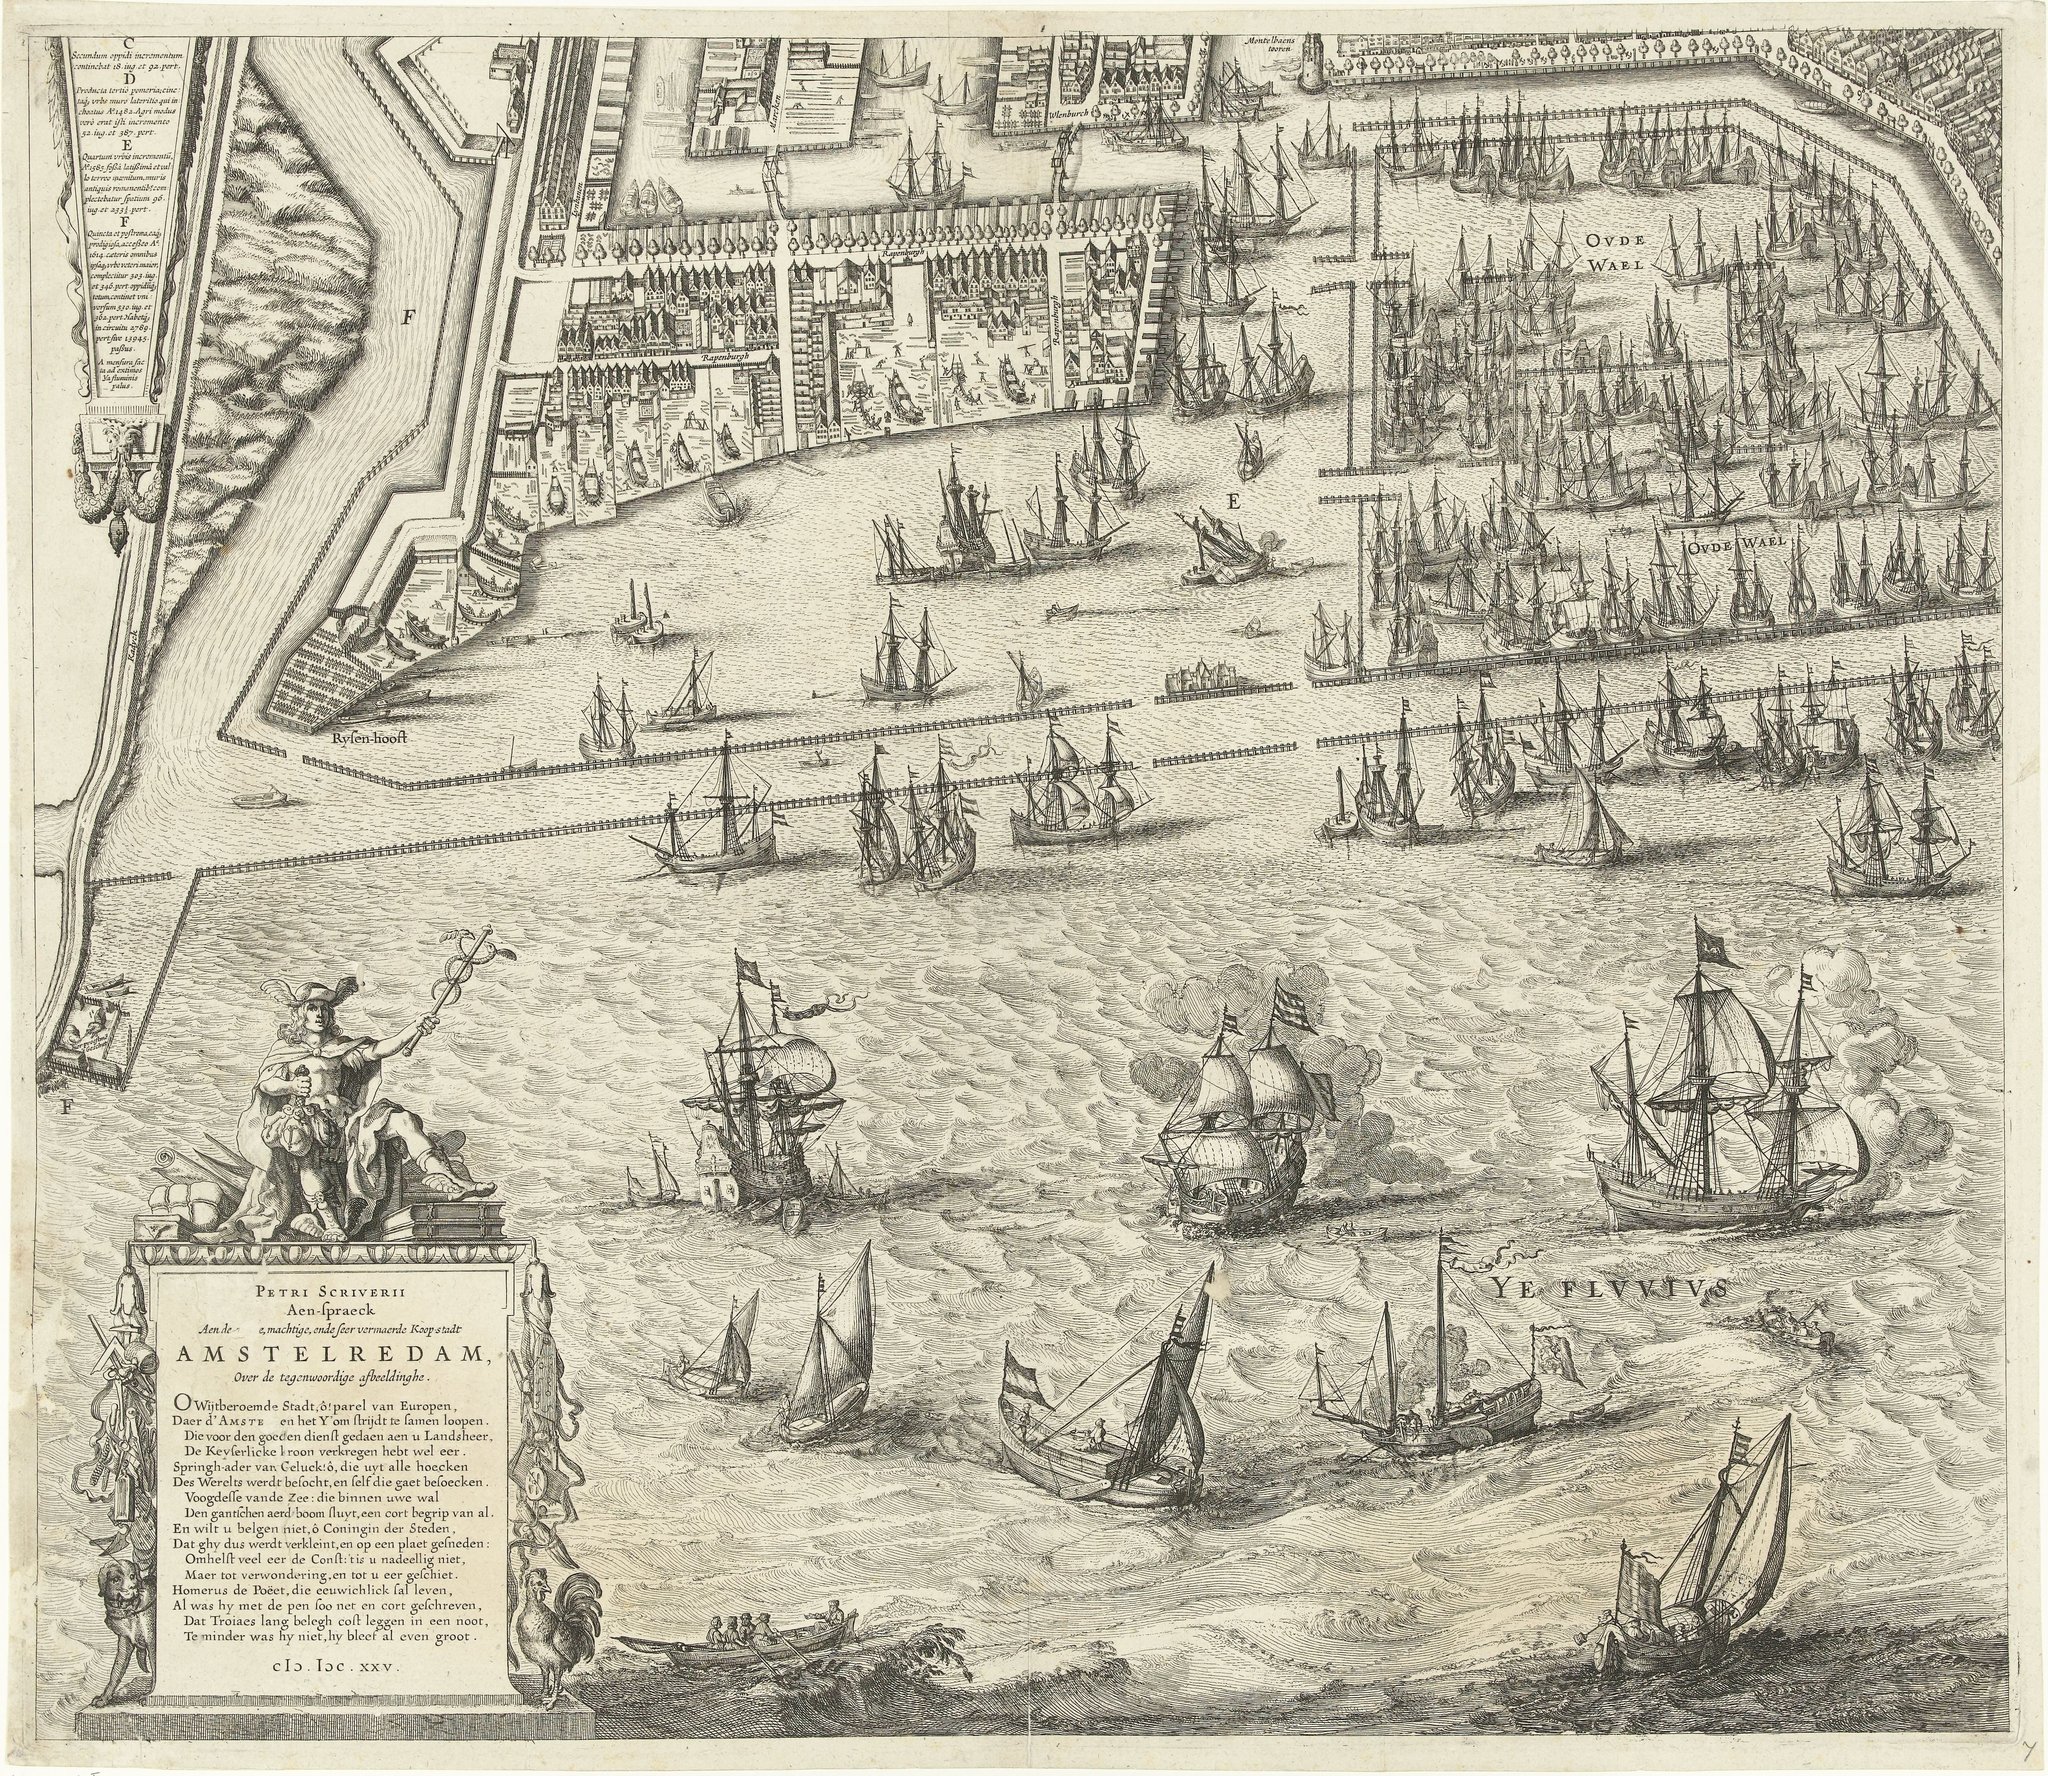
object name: print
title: Plattegrond van Amsterdam (blad linksonder)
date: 1625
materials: paper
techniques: etching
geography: northern netherlands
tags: maps of cities, amsterdam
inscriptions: collector's mark: Lugt 2228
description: Grote plattegrond van de stad Amsterdam uit 1625. Linksboven een gezicht op de stad en rechtsboven een kaart van de omgeving. Rechts een lijst met de namen van straten aan de Oude en de Nieuwe stadszijde. De plattegrond is samengesteld uit negen platen, waarvan twee ontbreken. Dit is het blad linksonder met de haven en het IJ en een gedicht op de stad Amsterdam door Petrus Scriverius.